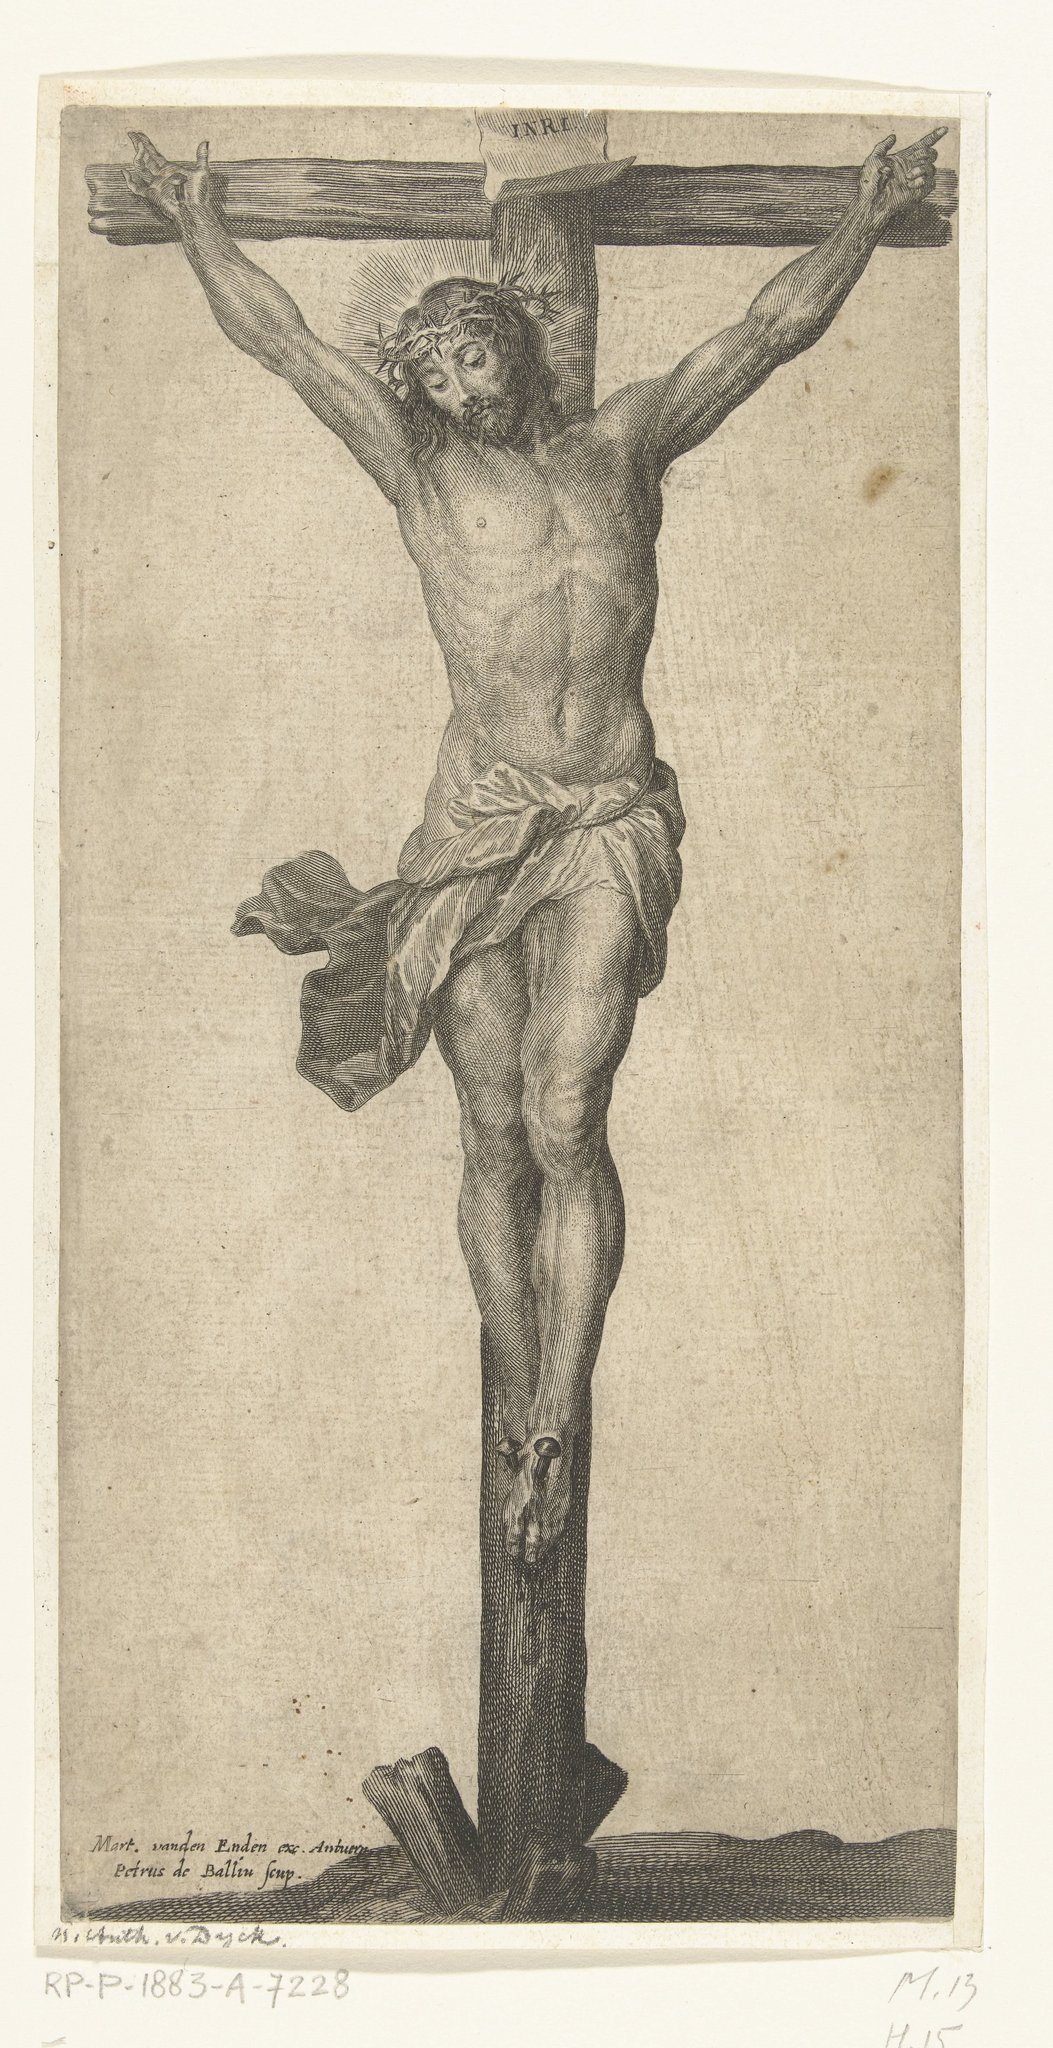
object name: print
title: Christus aan het kruis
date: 1623-1660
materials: paper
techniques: engraving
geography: antwerp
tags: christ suffering (with crown of thorns, head usually turned sidewards)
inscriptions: collector's mark: Lugt 2228